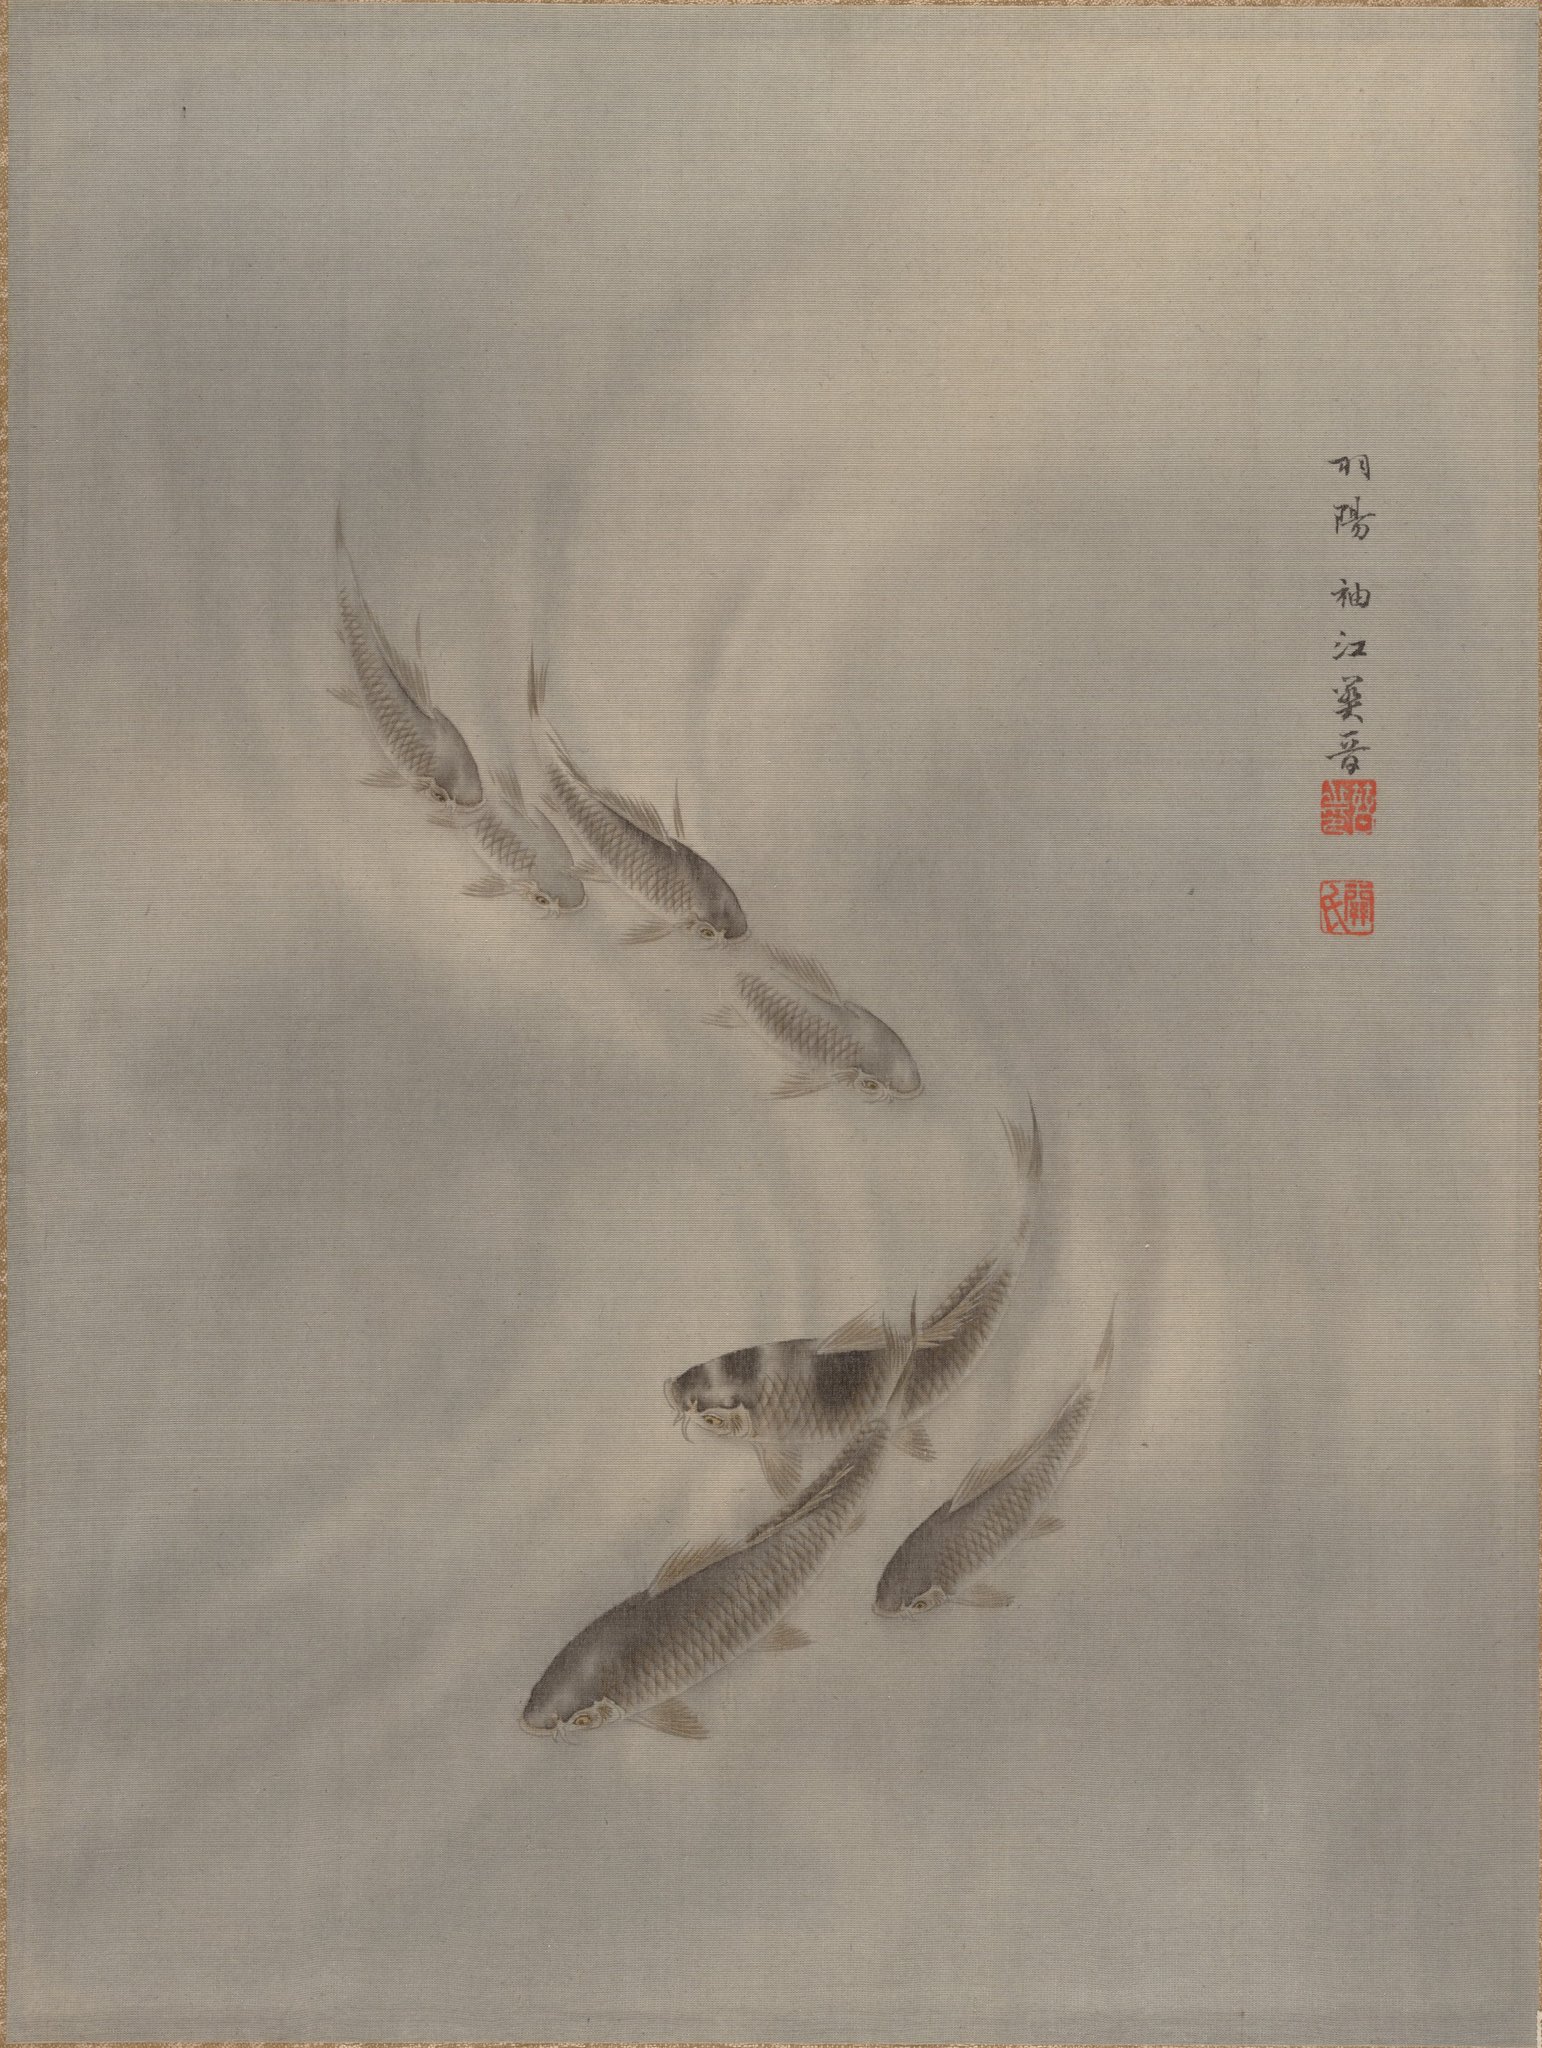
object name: album leaf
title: School of Fishes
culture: japanese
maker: seki shūkō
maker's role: artist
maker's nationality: japanese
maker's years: 1858-1915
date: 1890-1892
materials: ink, silk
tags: fish